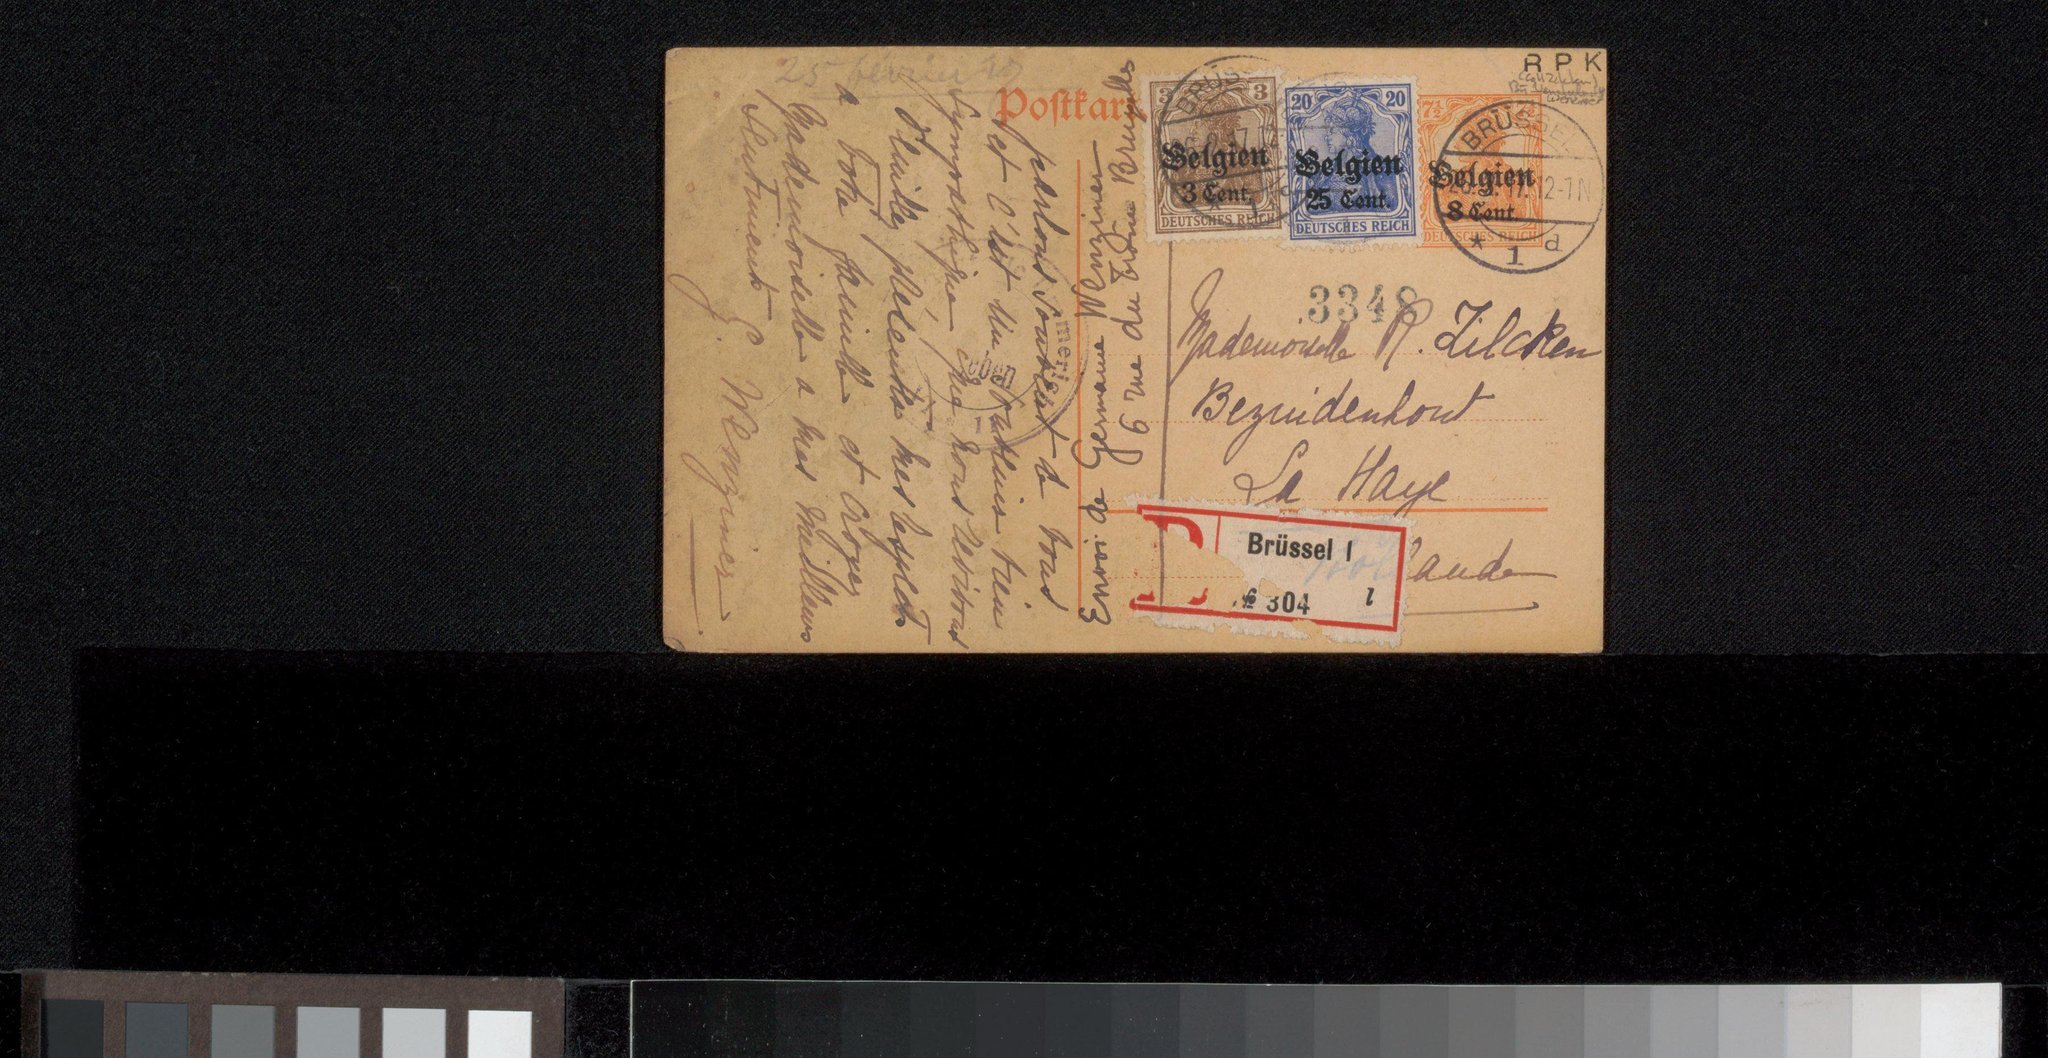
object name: postcard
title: Briefkaart aan Renée Hélène Laure Zilcken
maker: germaine wenziner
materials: cardboard, ink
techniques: pen, writing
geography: brussels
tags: voorburg, renée hélène laure zilcken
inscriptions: collector's mark: ‘RPK’